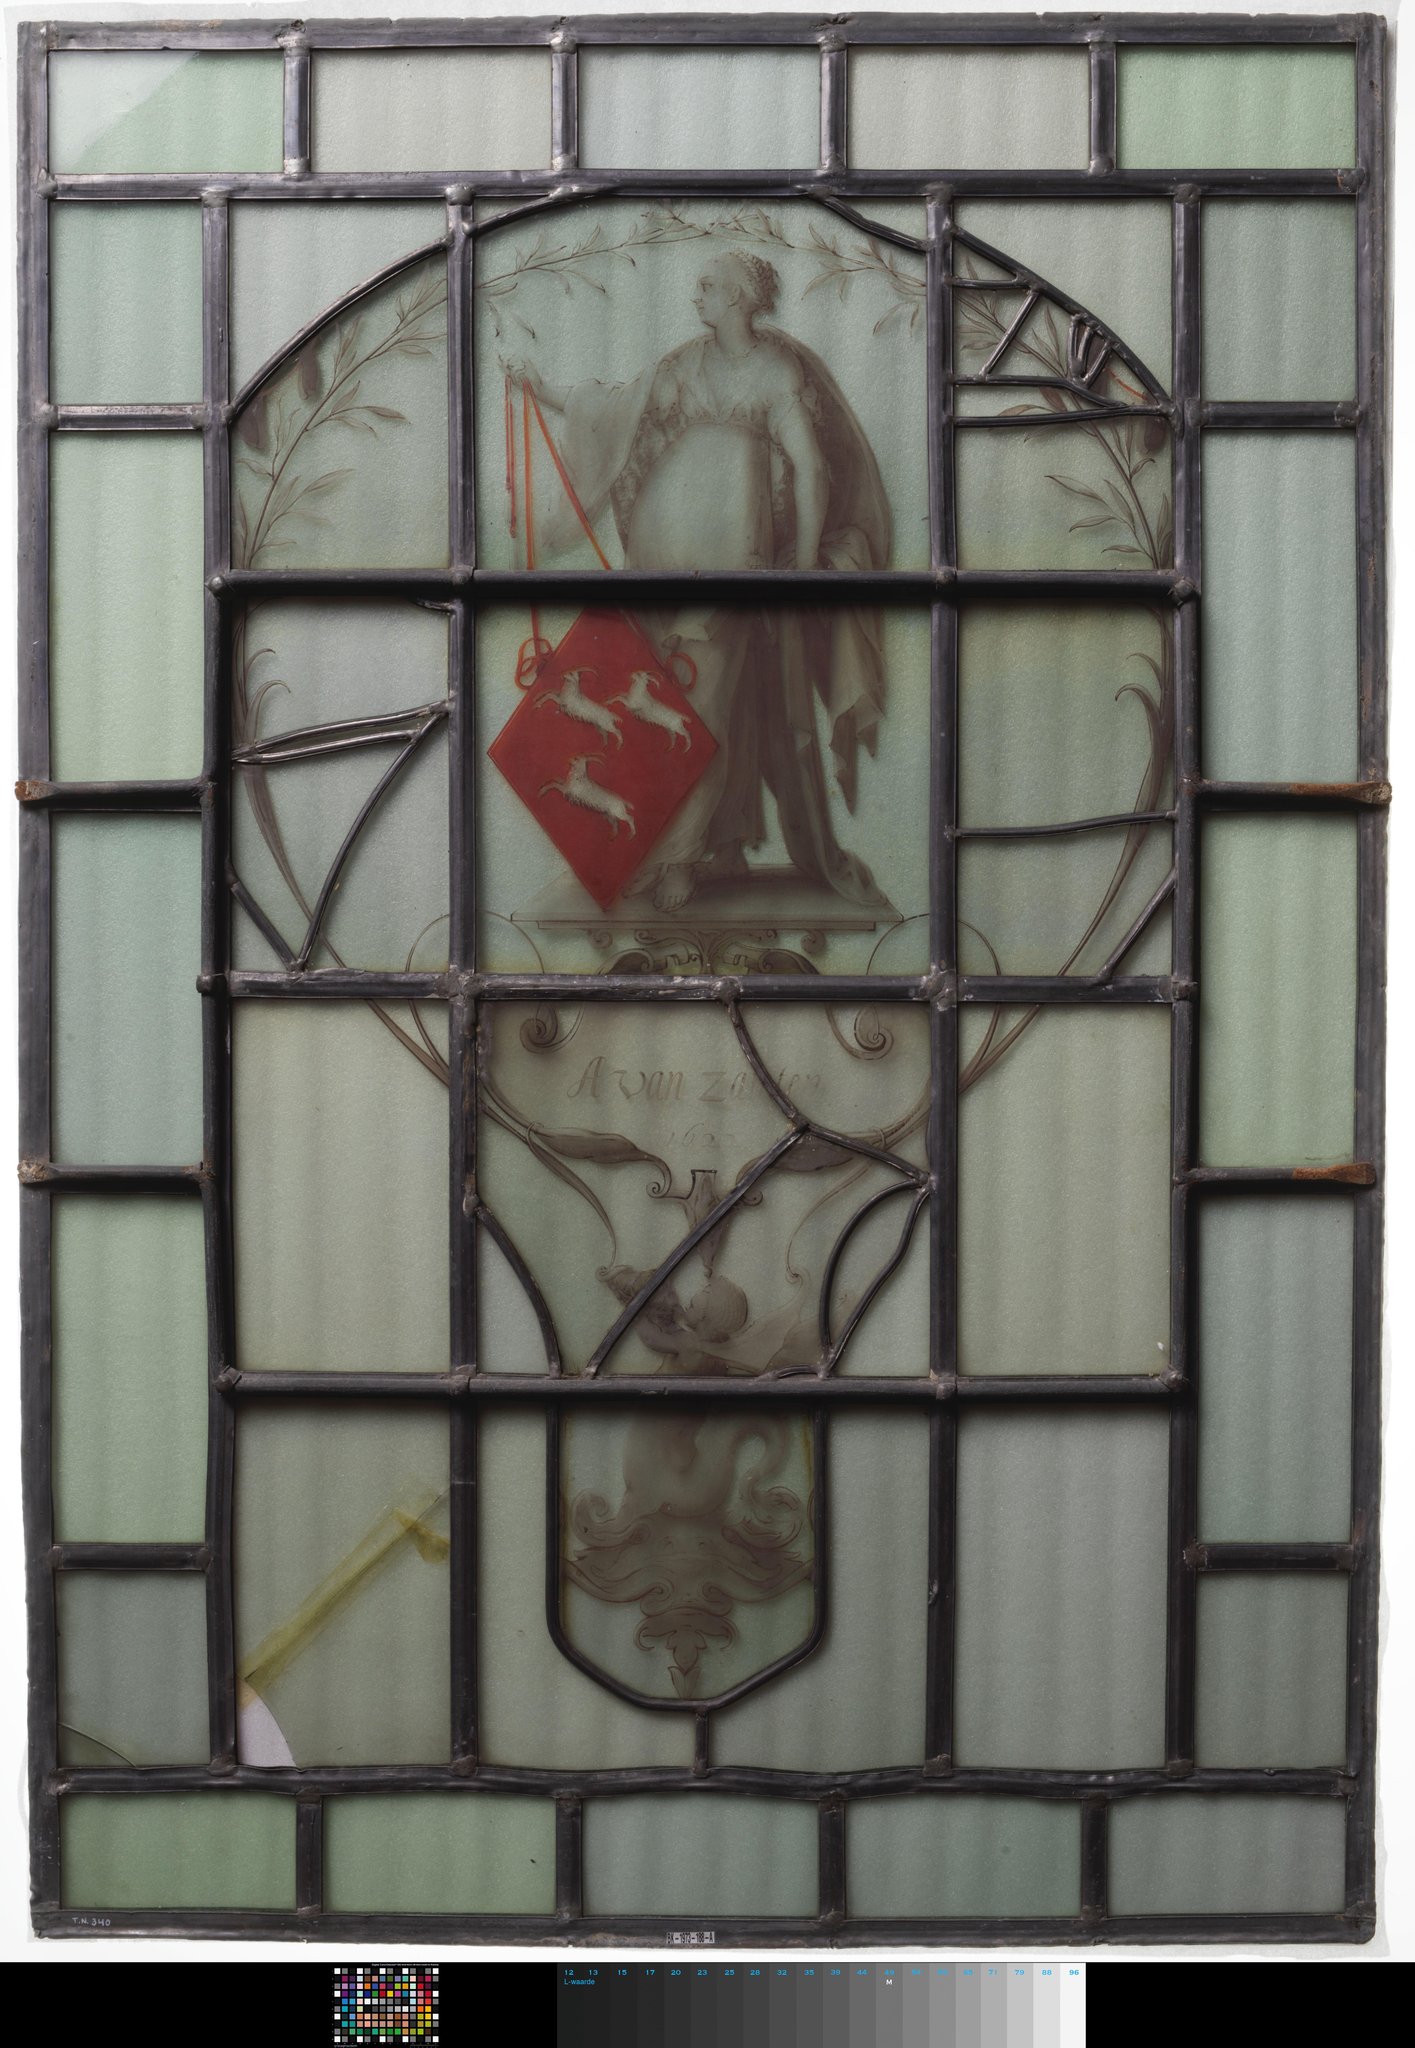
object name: light window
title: Ruit met wapen met opschrift "A. van Zanten 1622"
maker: Anonymous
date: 1622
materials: glass, lead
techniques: leading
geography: low countries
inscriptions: date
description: Gebrandschilderde ruit met wapen met opschrift A. van Zanten 1622, in grisaille en rood. Het wapen wordt gehouden door een vrouwenfiguur. Onder het wapen een op een schelp blazende meermin.